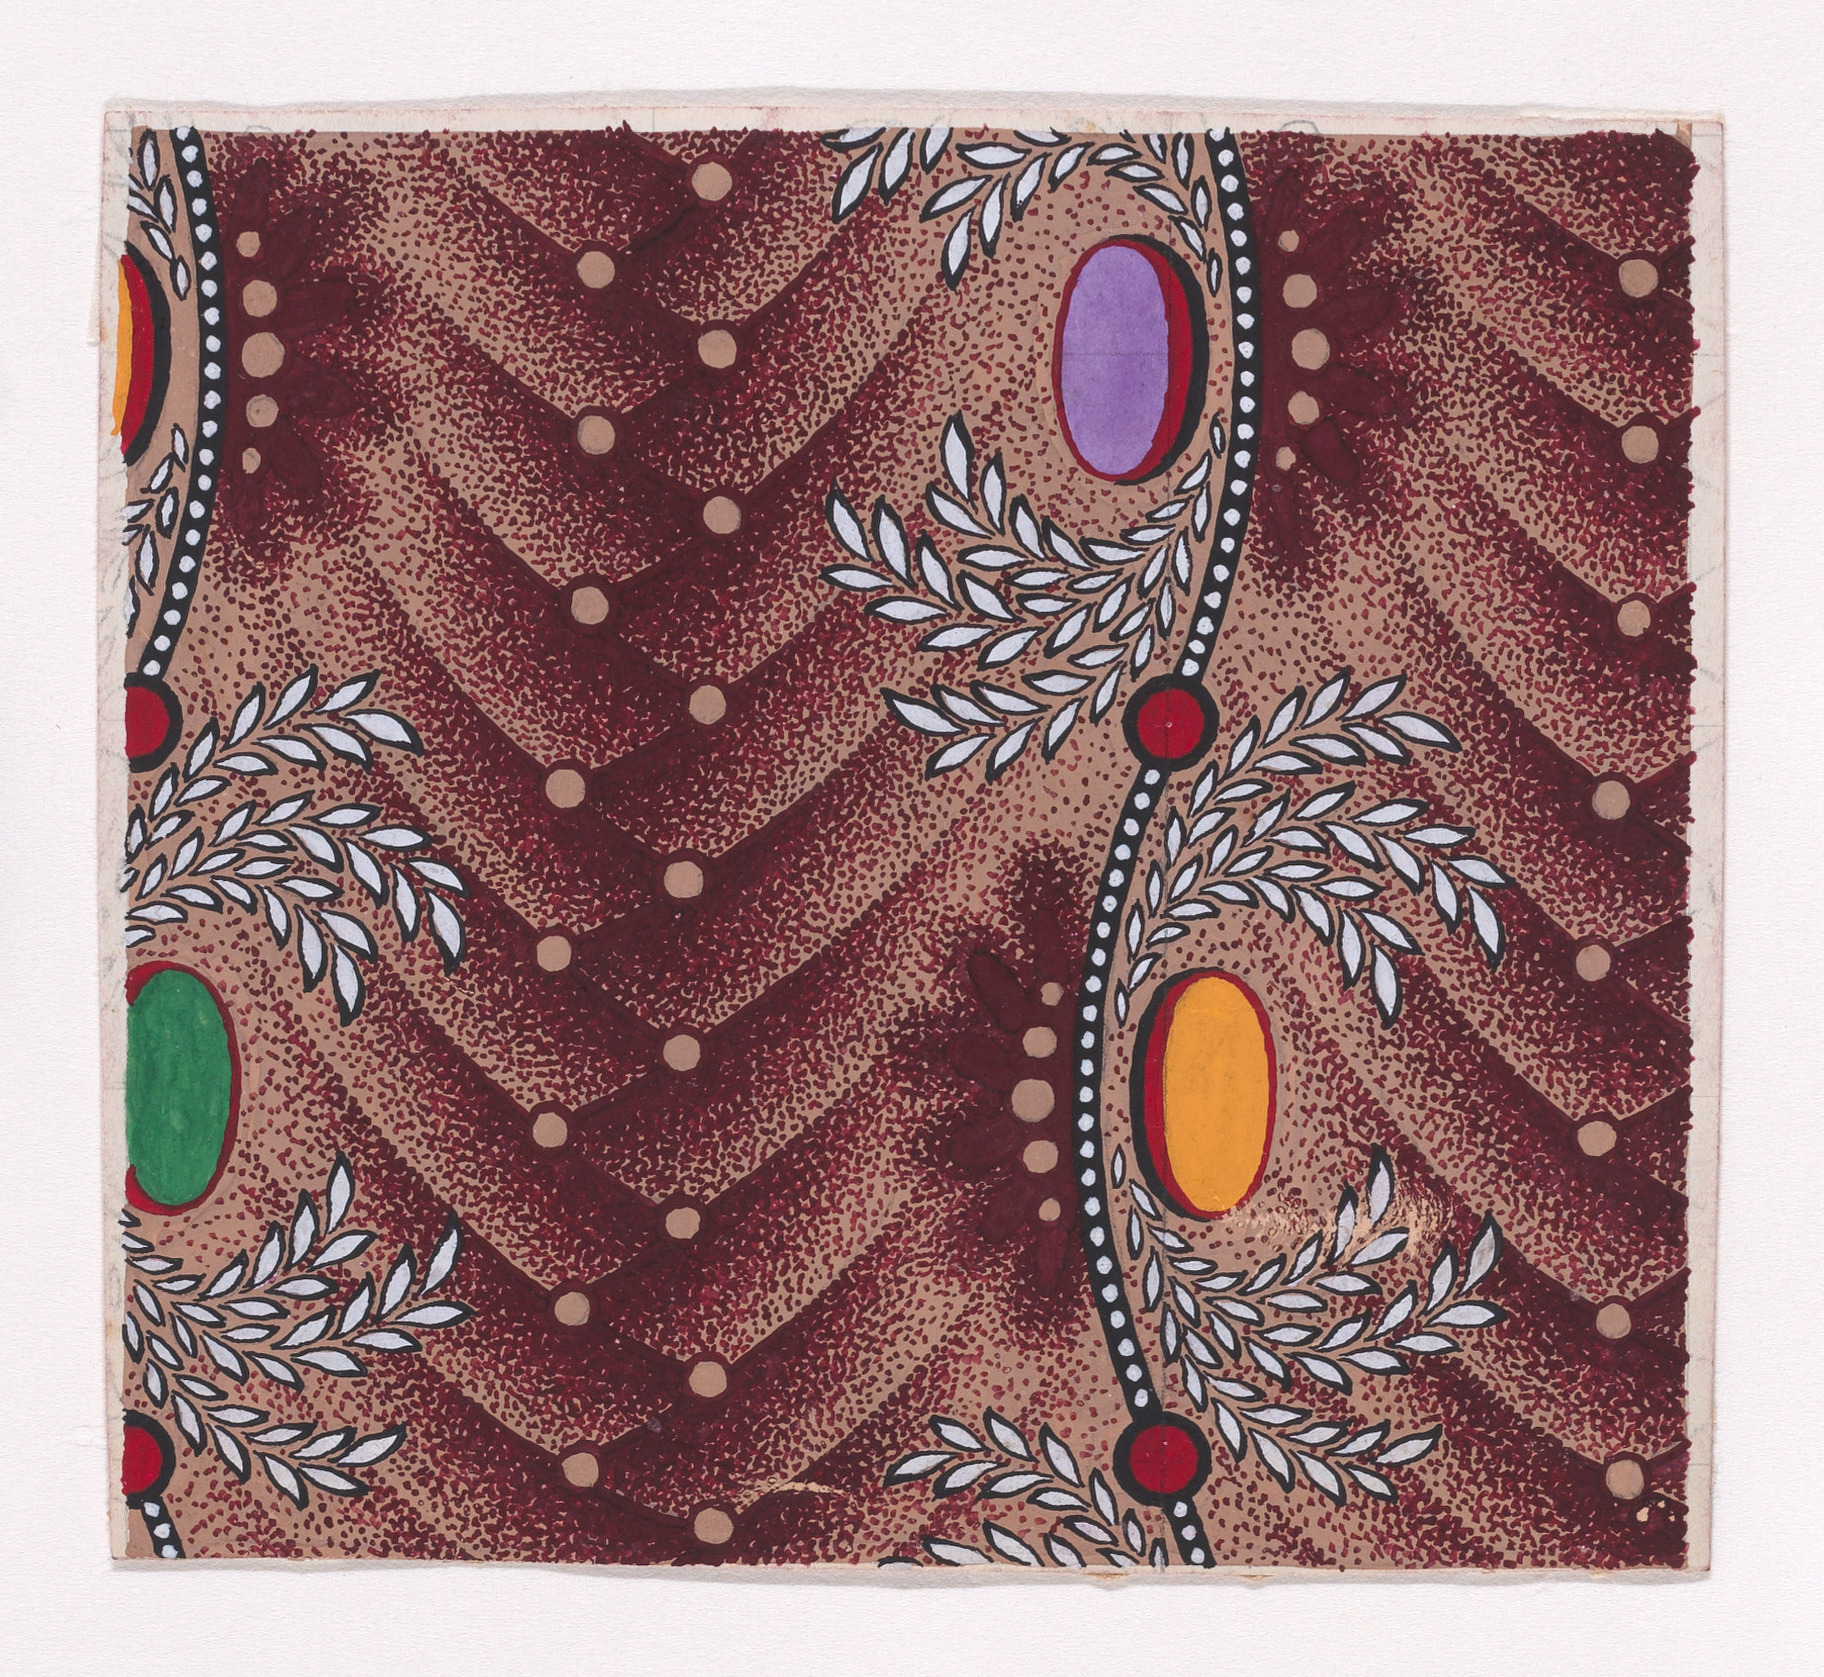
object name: drawing ornament architecture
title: Textile Design with Alternating Vertical Stripes of Zig-Zagging Pearls Over Overlapping Scales and Ovals Framed By Crowns of Laurel Leaves Placed Alternately Along an Undulating Line Adorned with Pearls and Circles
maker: anonymous, alsatian, 19th century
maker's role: artist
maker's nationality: alsatian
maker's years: 1800-1900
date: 1840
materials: gouache